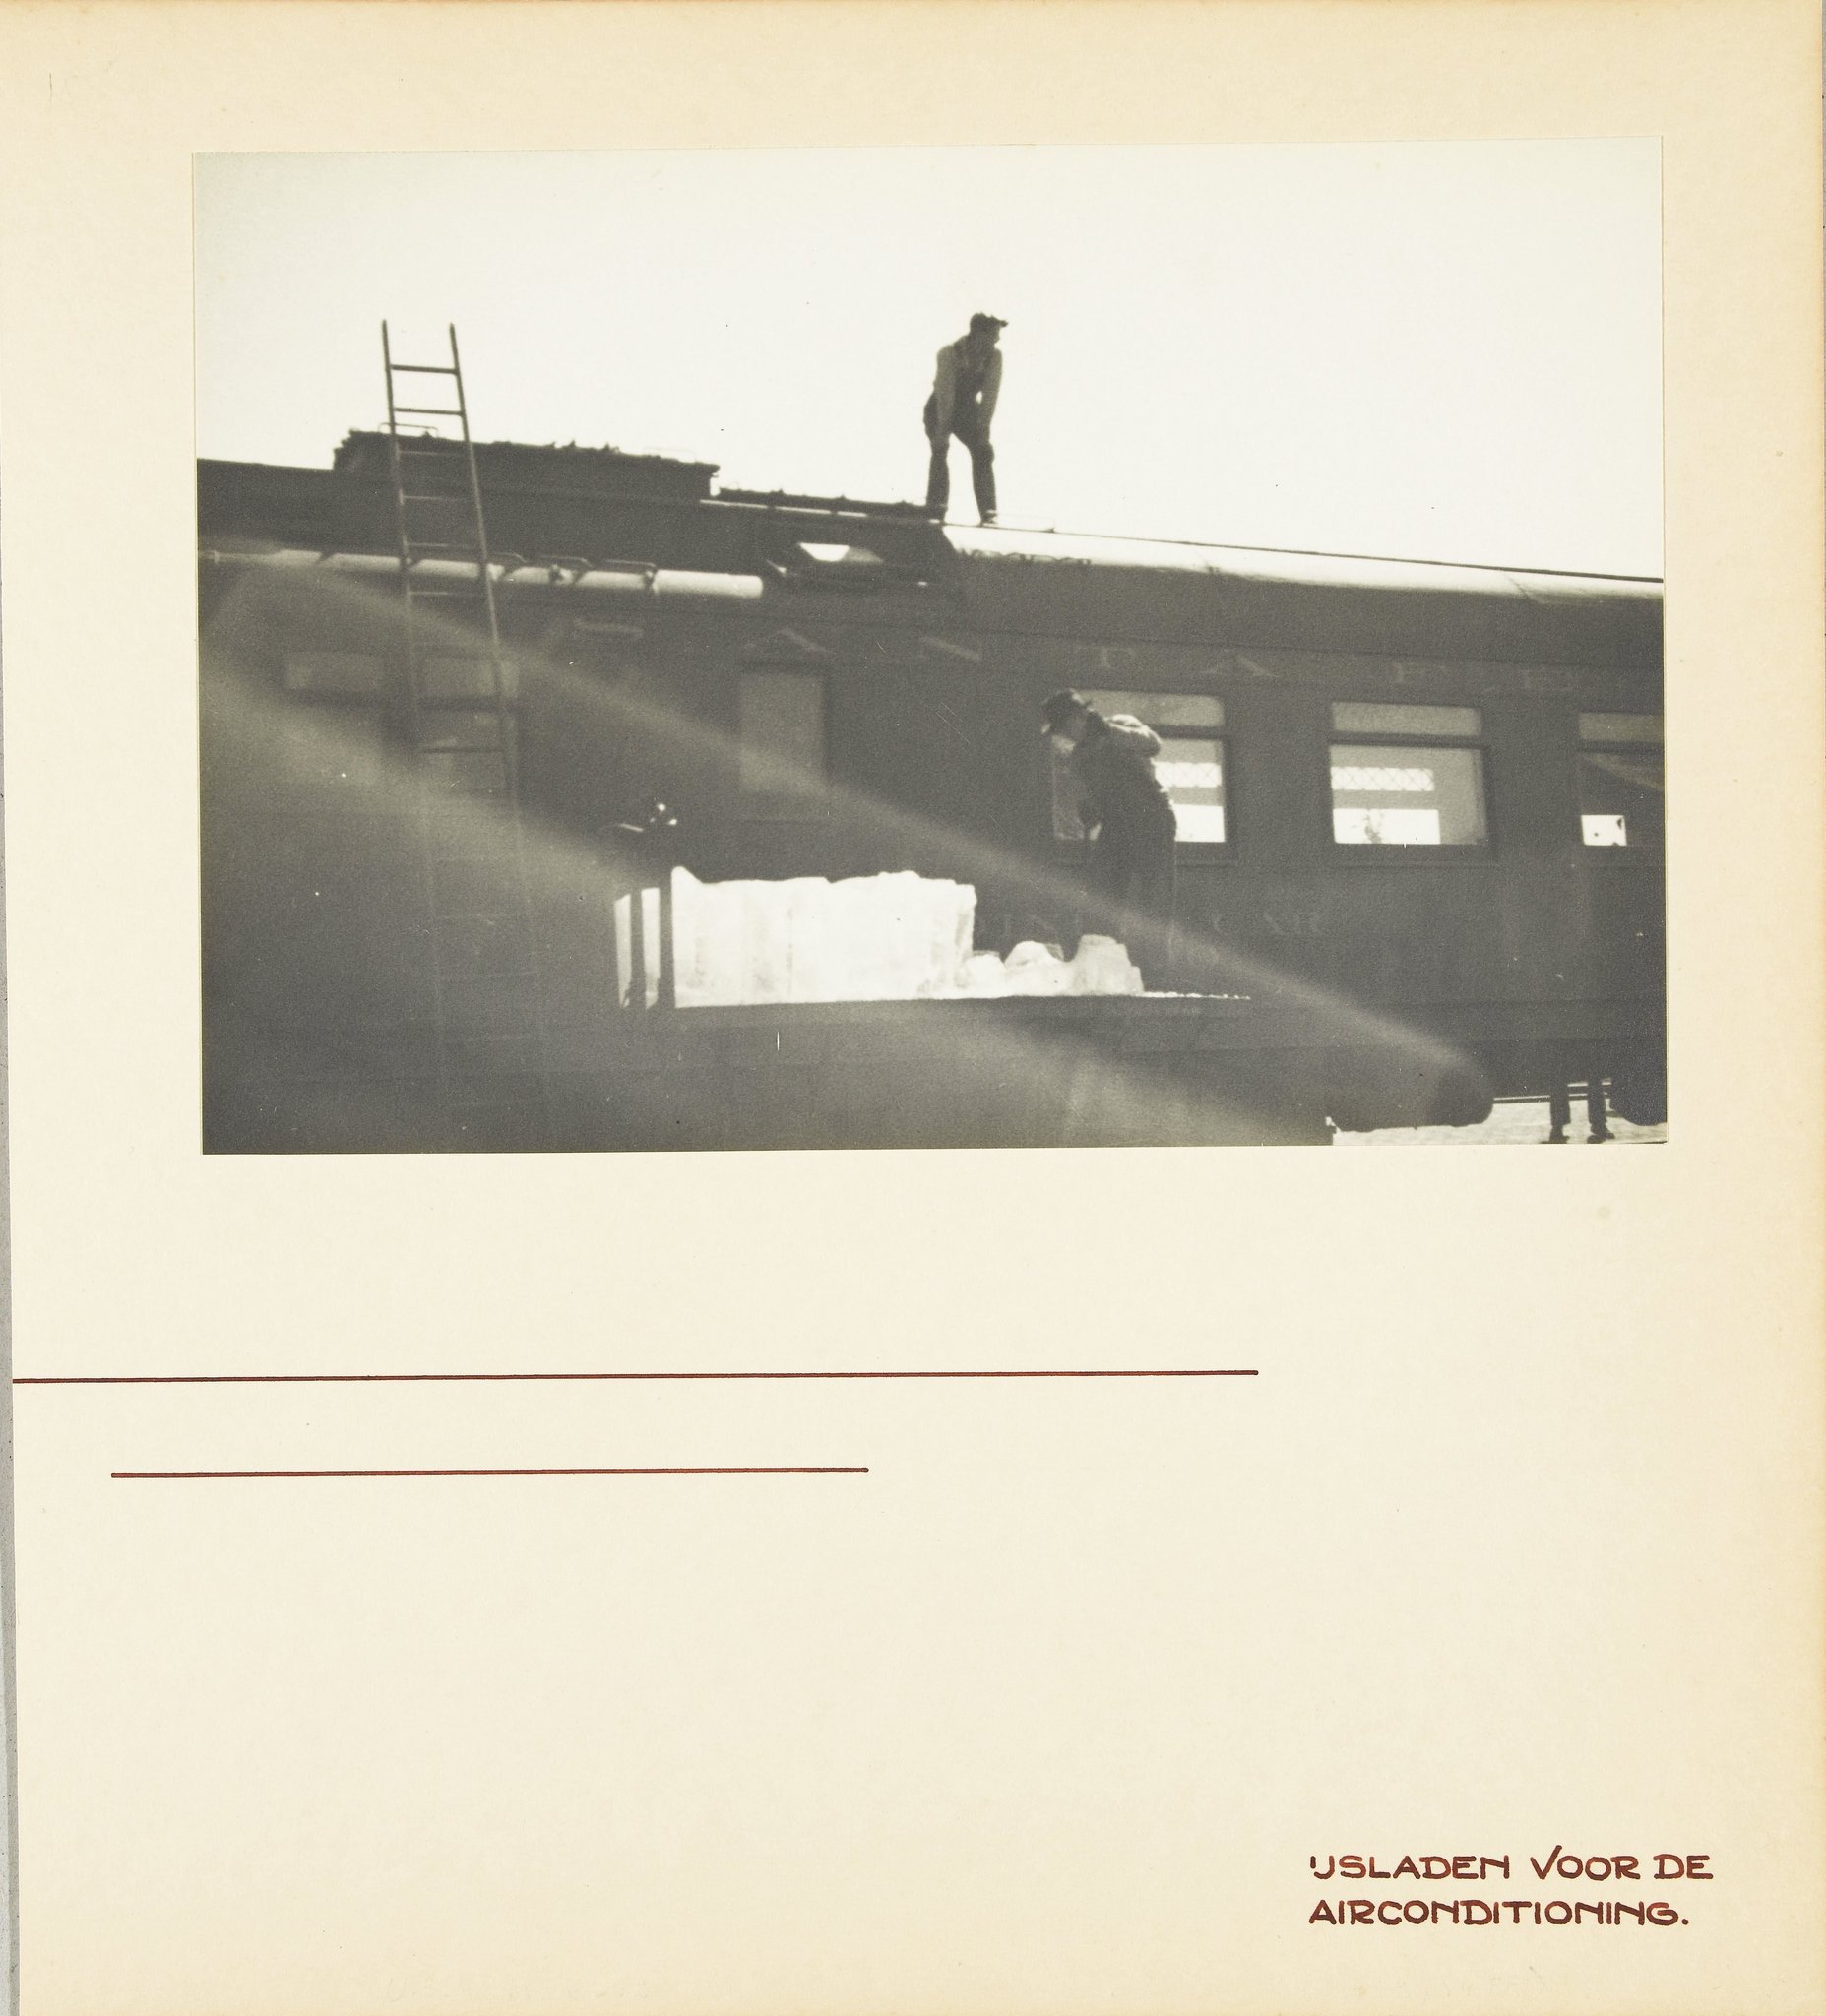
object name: photograph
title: Onbekende locatie in de Verenigde Staten: een trein die voorzien wordt van ijs voor de airconditioning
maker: wouter cool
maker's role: engineer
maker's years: 1877-1947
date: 1936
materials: cardboard, paper, photographic support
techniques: gelatin silver print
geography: united states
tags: passenger train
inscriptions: title: ‘IJSLADEN VOOR DE / AIRCONDITIONING.’